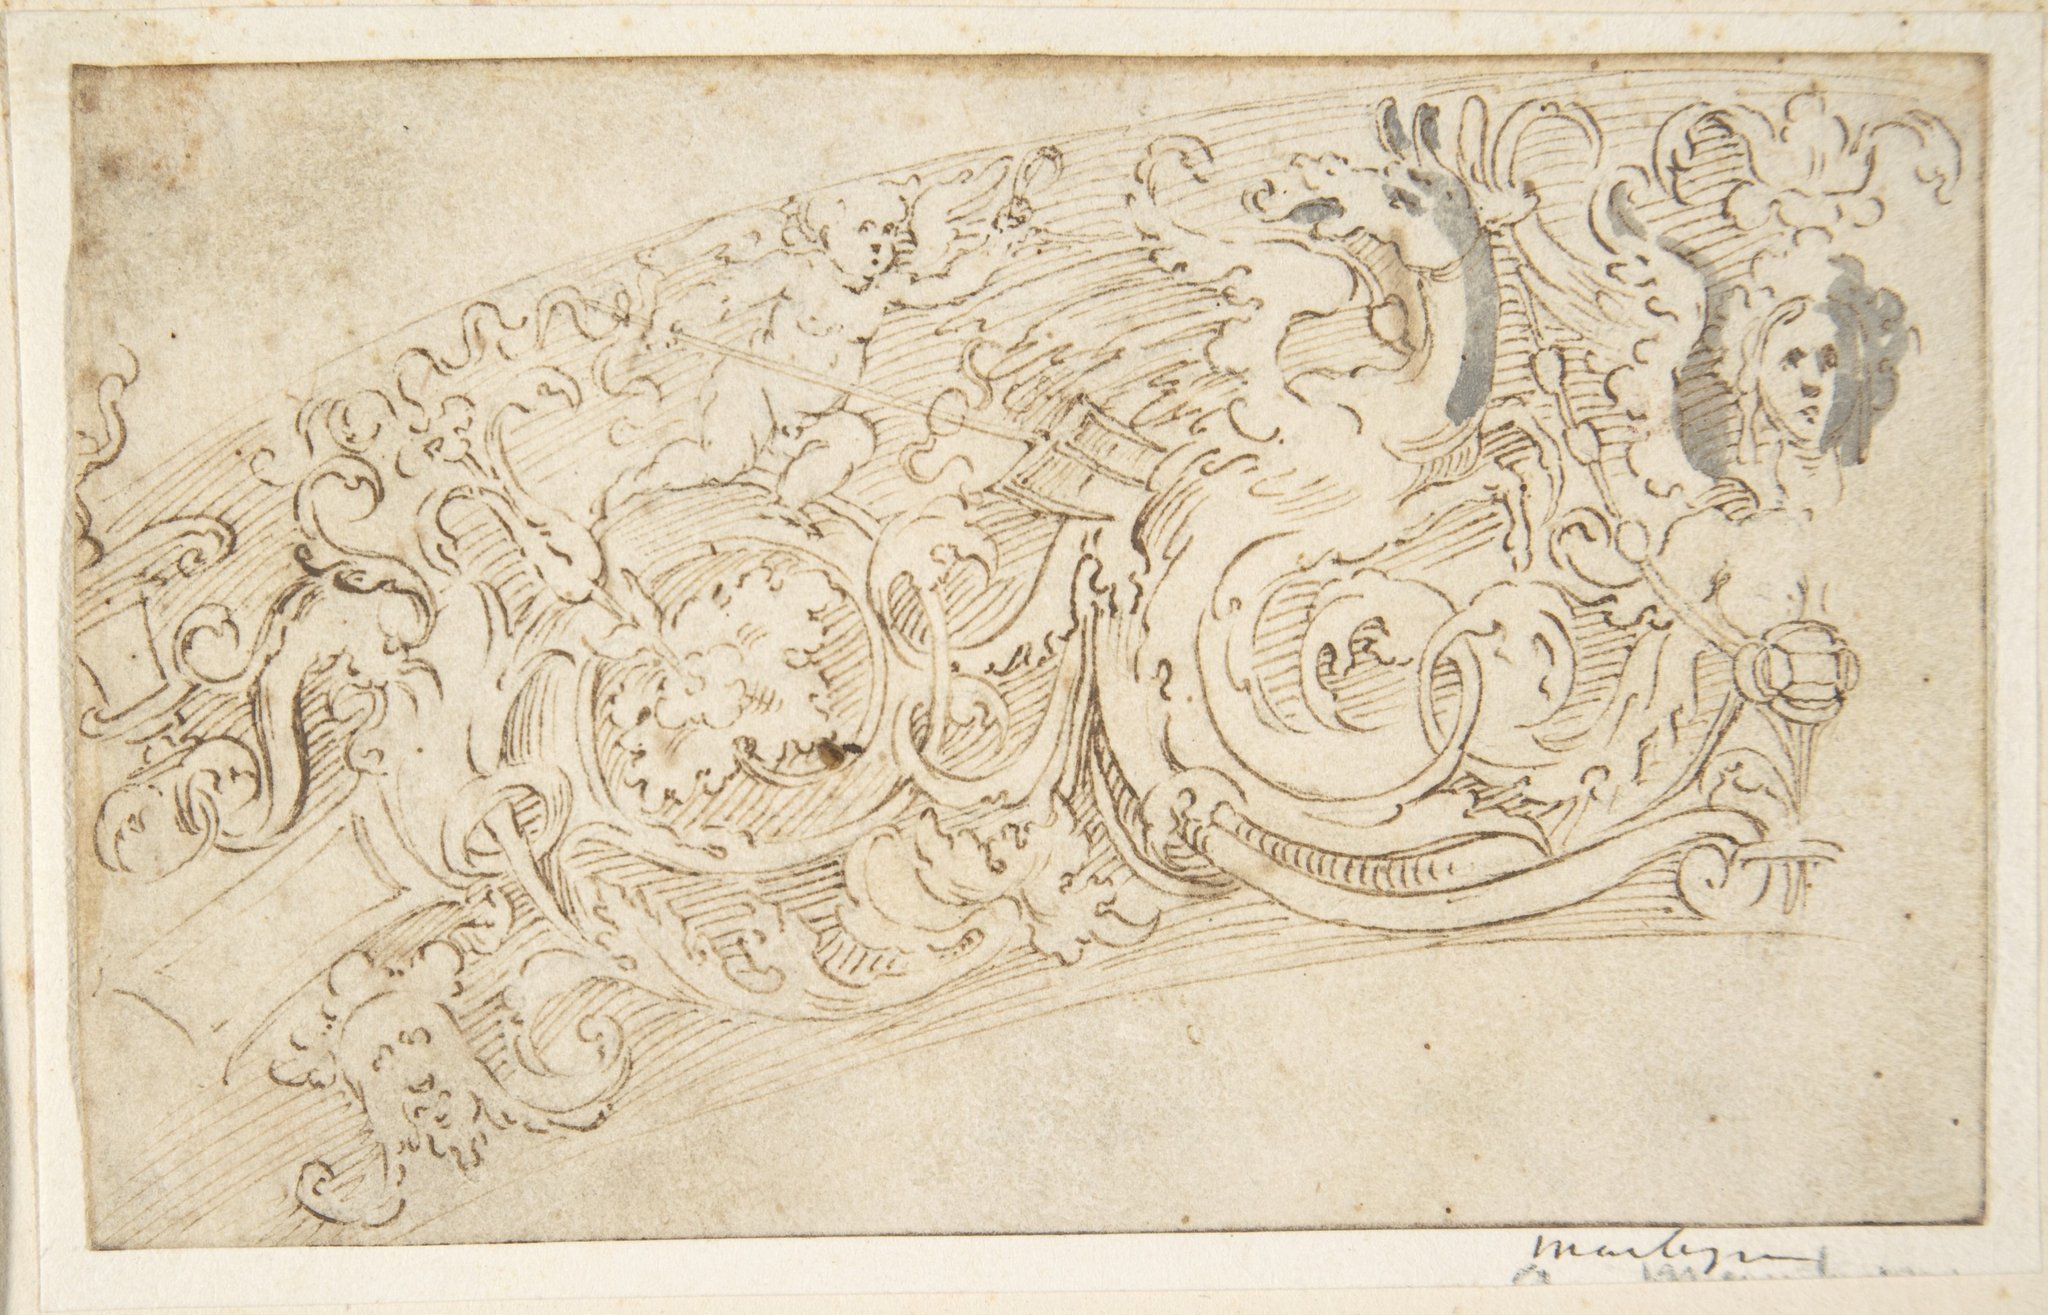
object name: drawing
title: Part of a Circular Frieze with a Sphynx and a Putto with a Hybrid Creature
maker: anonymous, italian, 16th to 17th century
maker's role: artist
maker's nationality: italian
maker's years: 1500-1700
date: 1500-1700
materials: ink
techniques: brush, pen, wash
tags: sphinx,putti